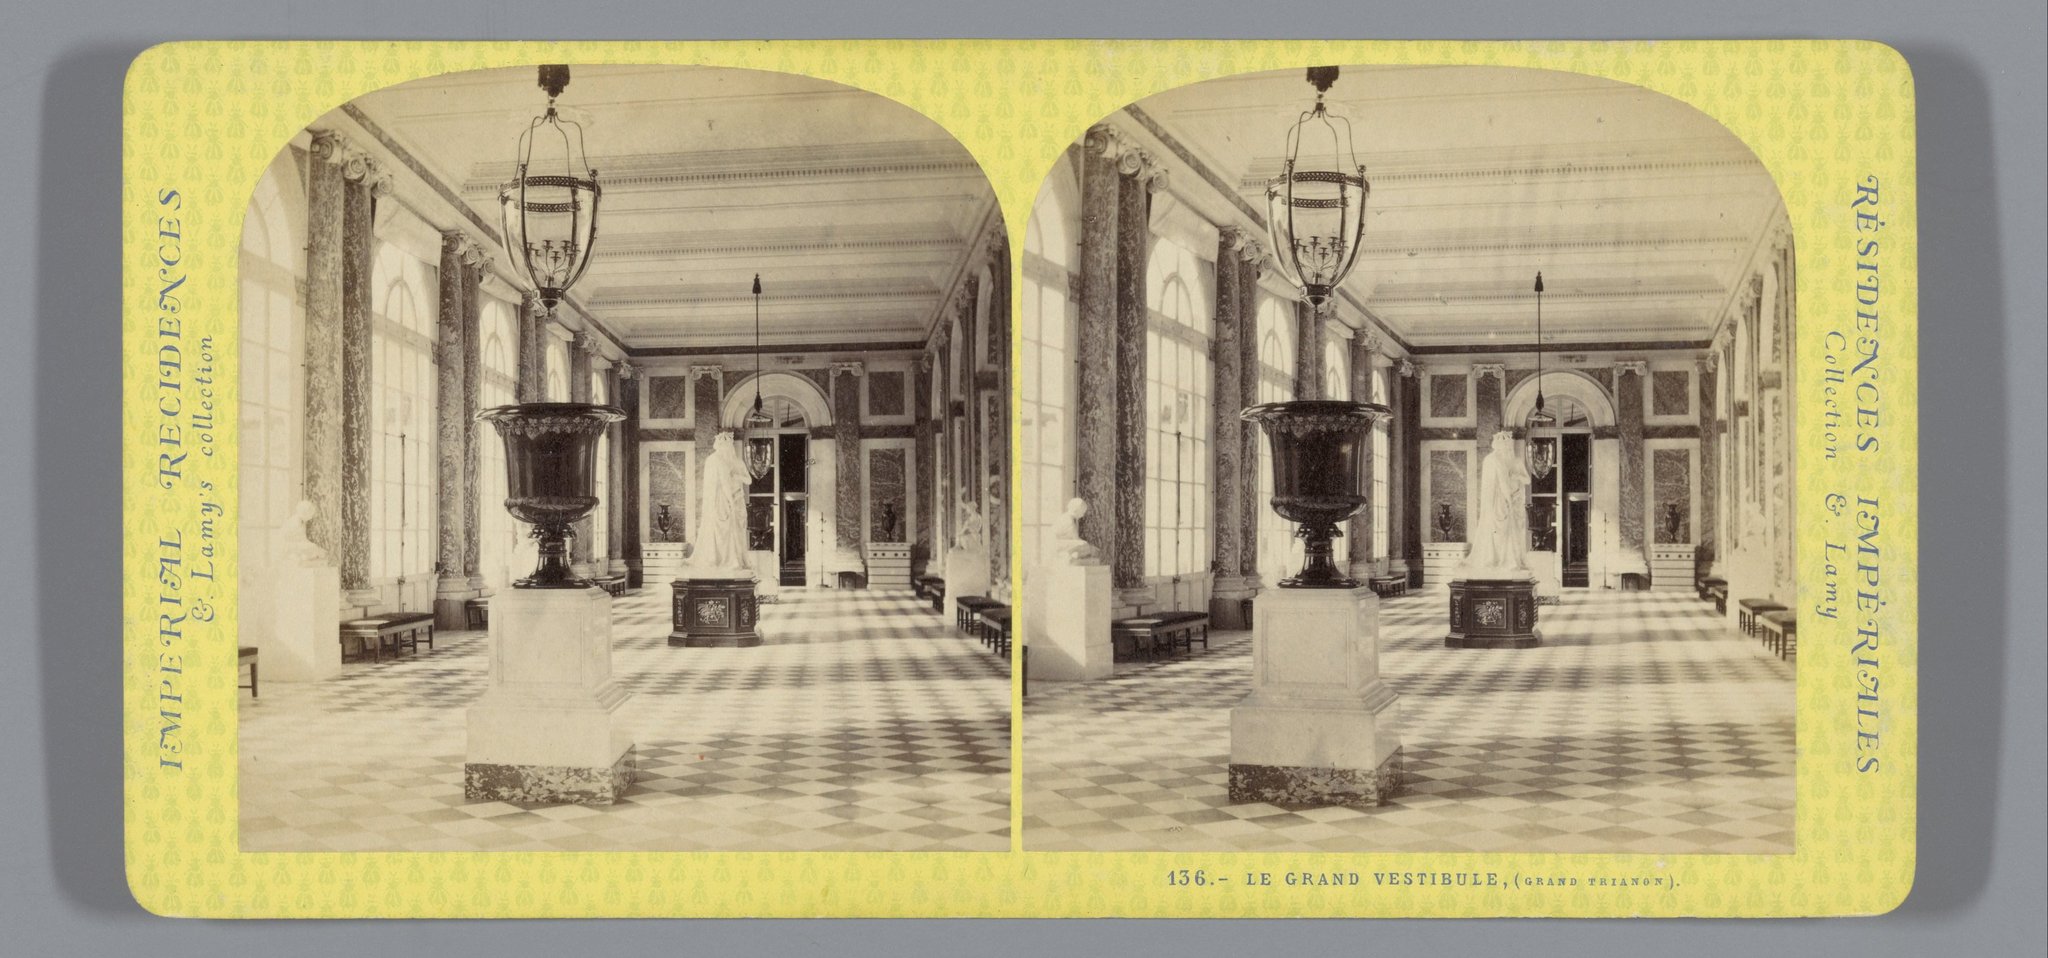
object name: stereograph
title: Imperial Residences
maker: ernest eléonor pierre lamy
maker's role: publisher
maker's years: 1828-1900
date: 1860-1880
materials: cardboard, photographic support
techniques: albumen print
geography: grand trianon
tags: vestibule, hall, interior ~ representation of a building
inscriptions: number: ‘136.’, inscription: ‘E. Lamy's collection’